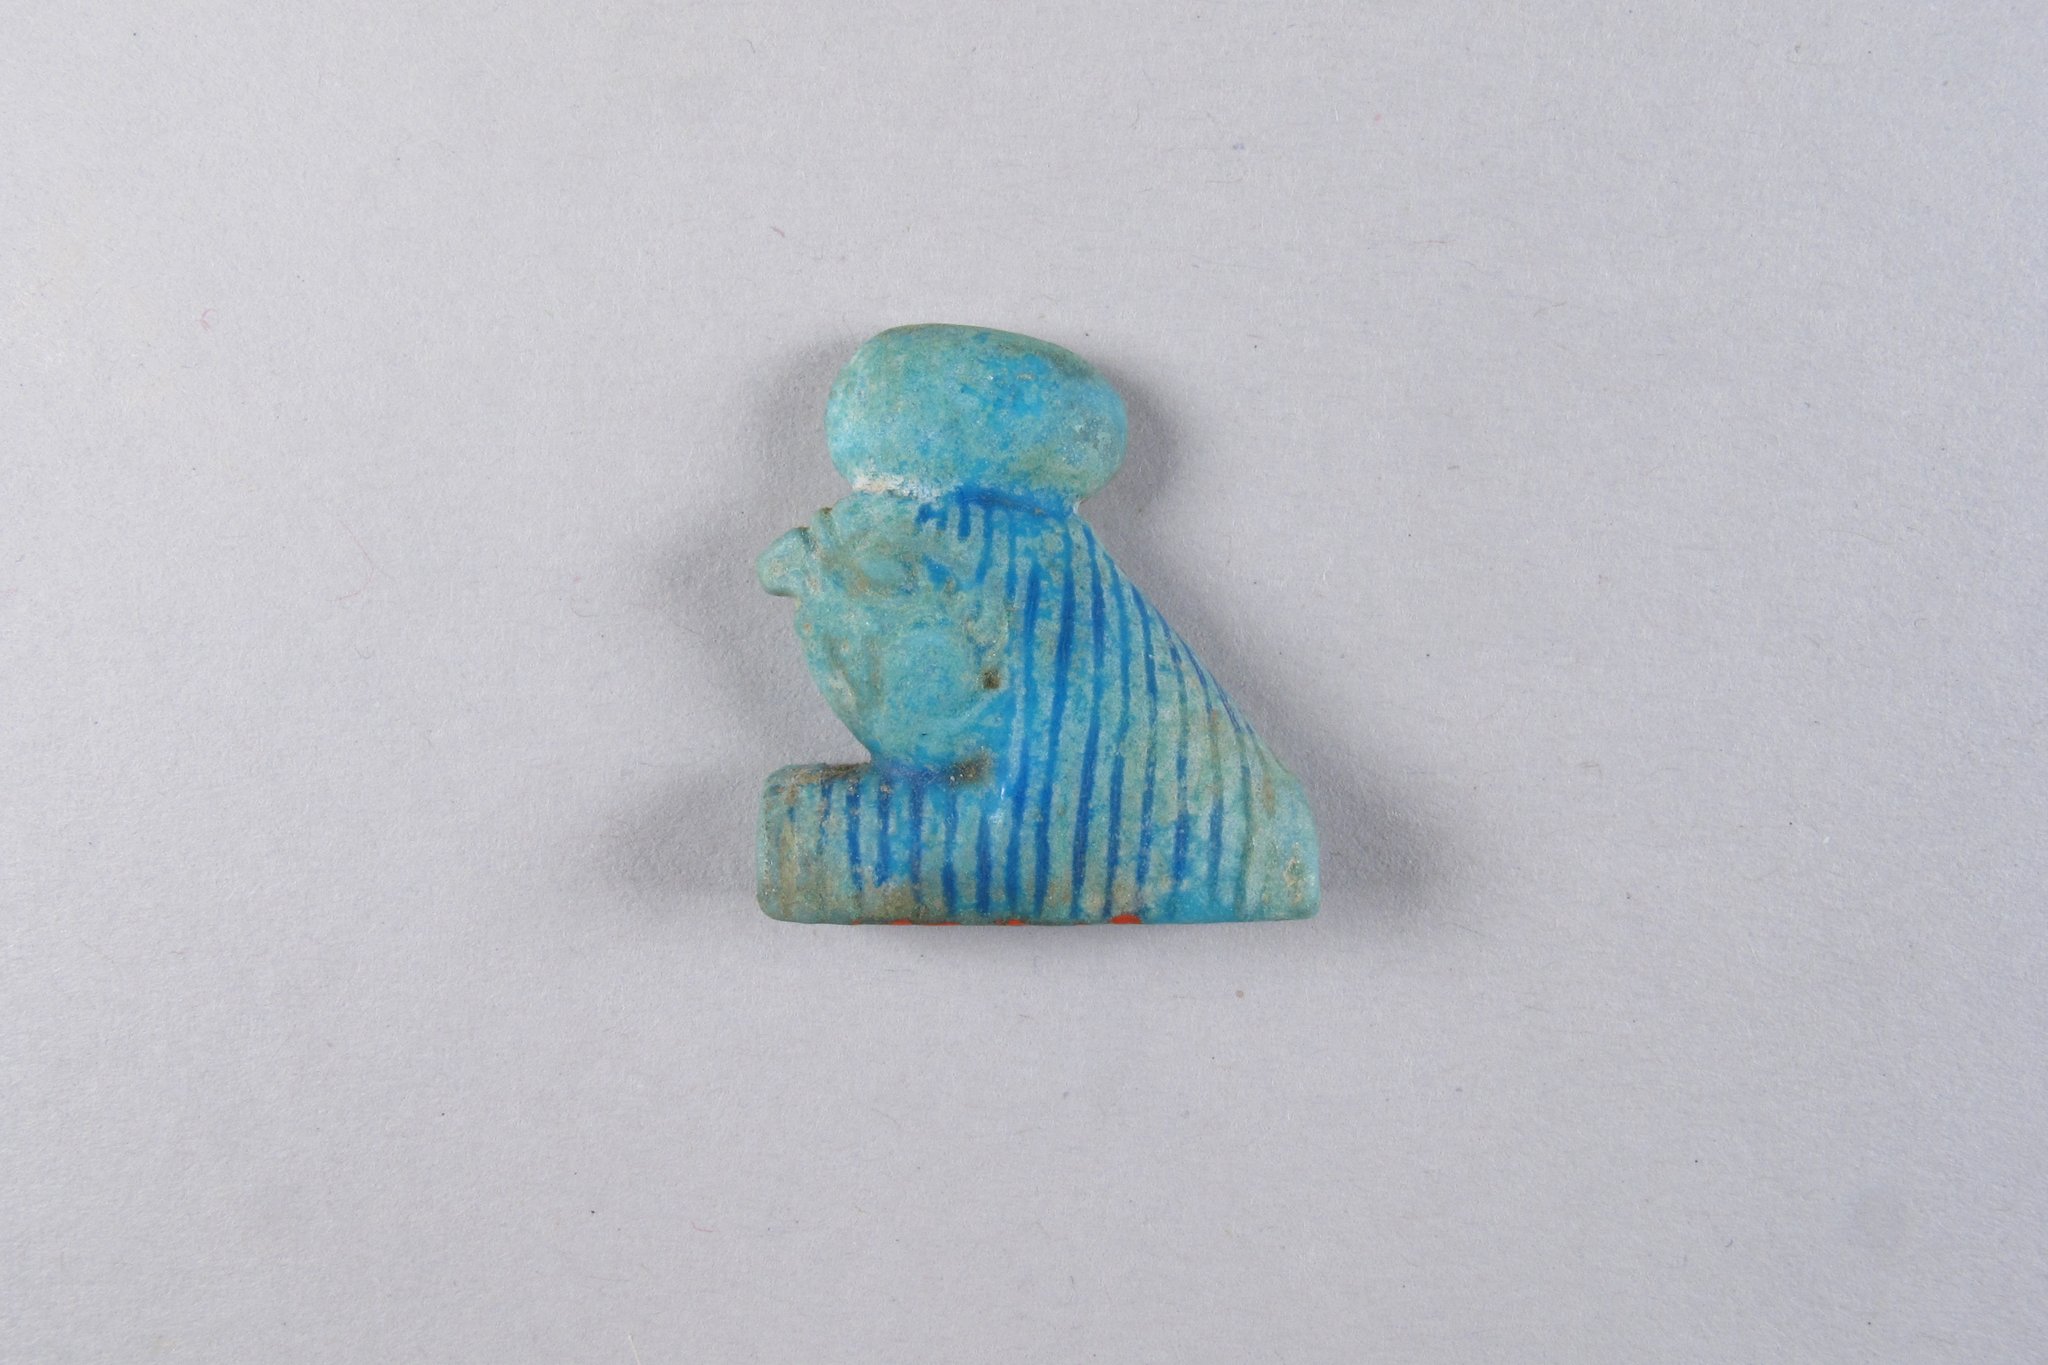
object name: collar terminal, falcon head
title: Collar terminal decorated with head of a falcon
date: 664-332 BCE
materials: faience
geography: egypt